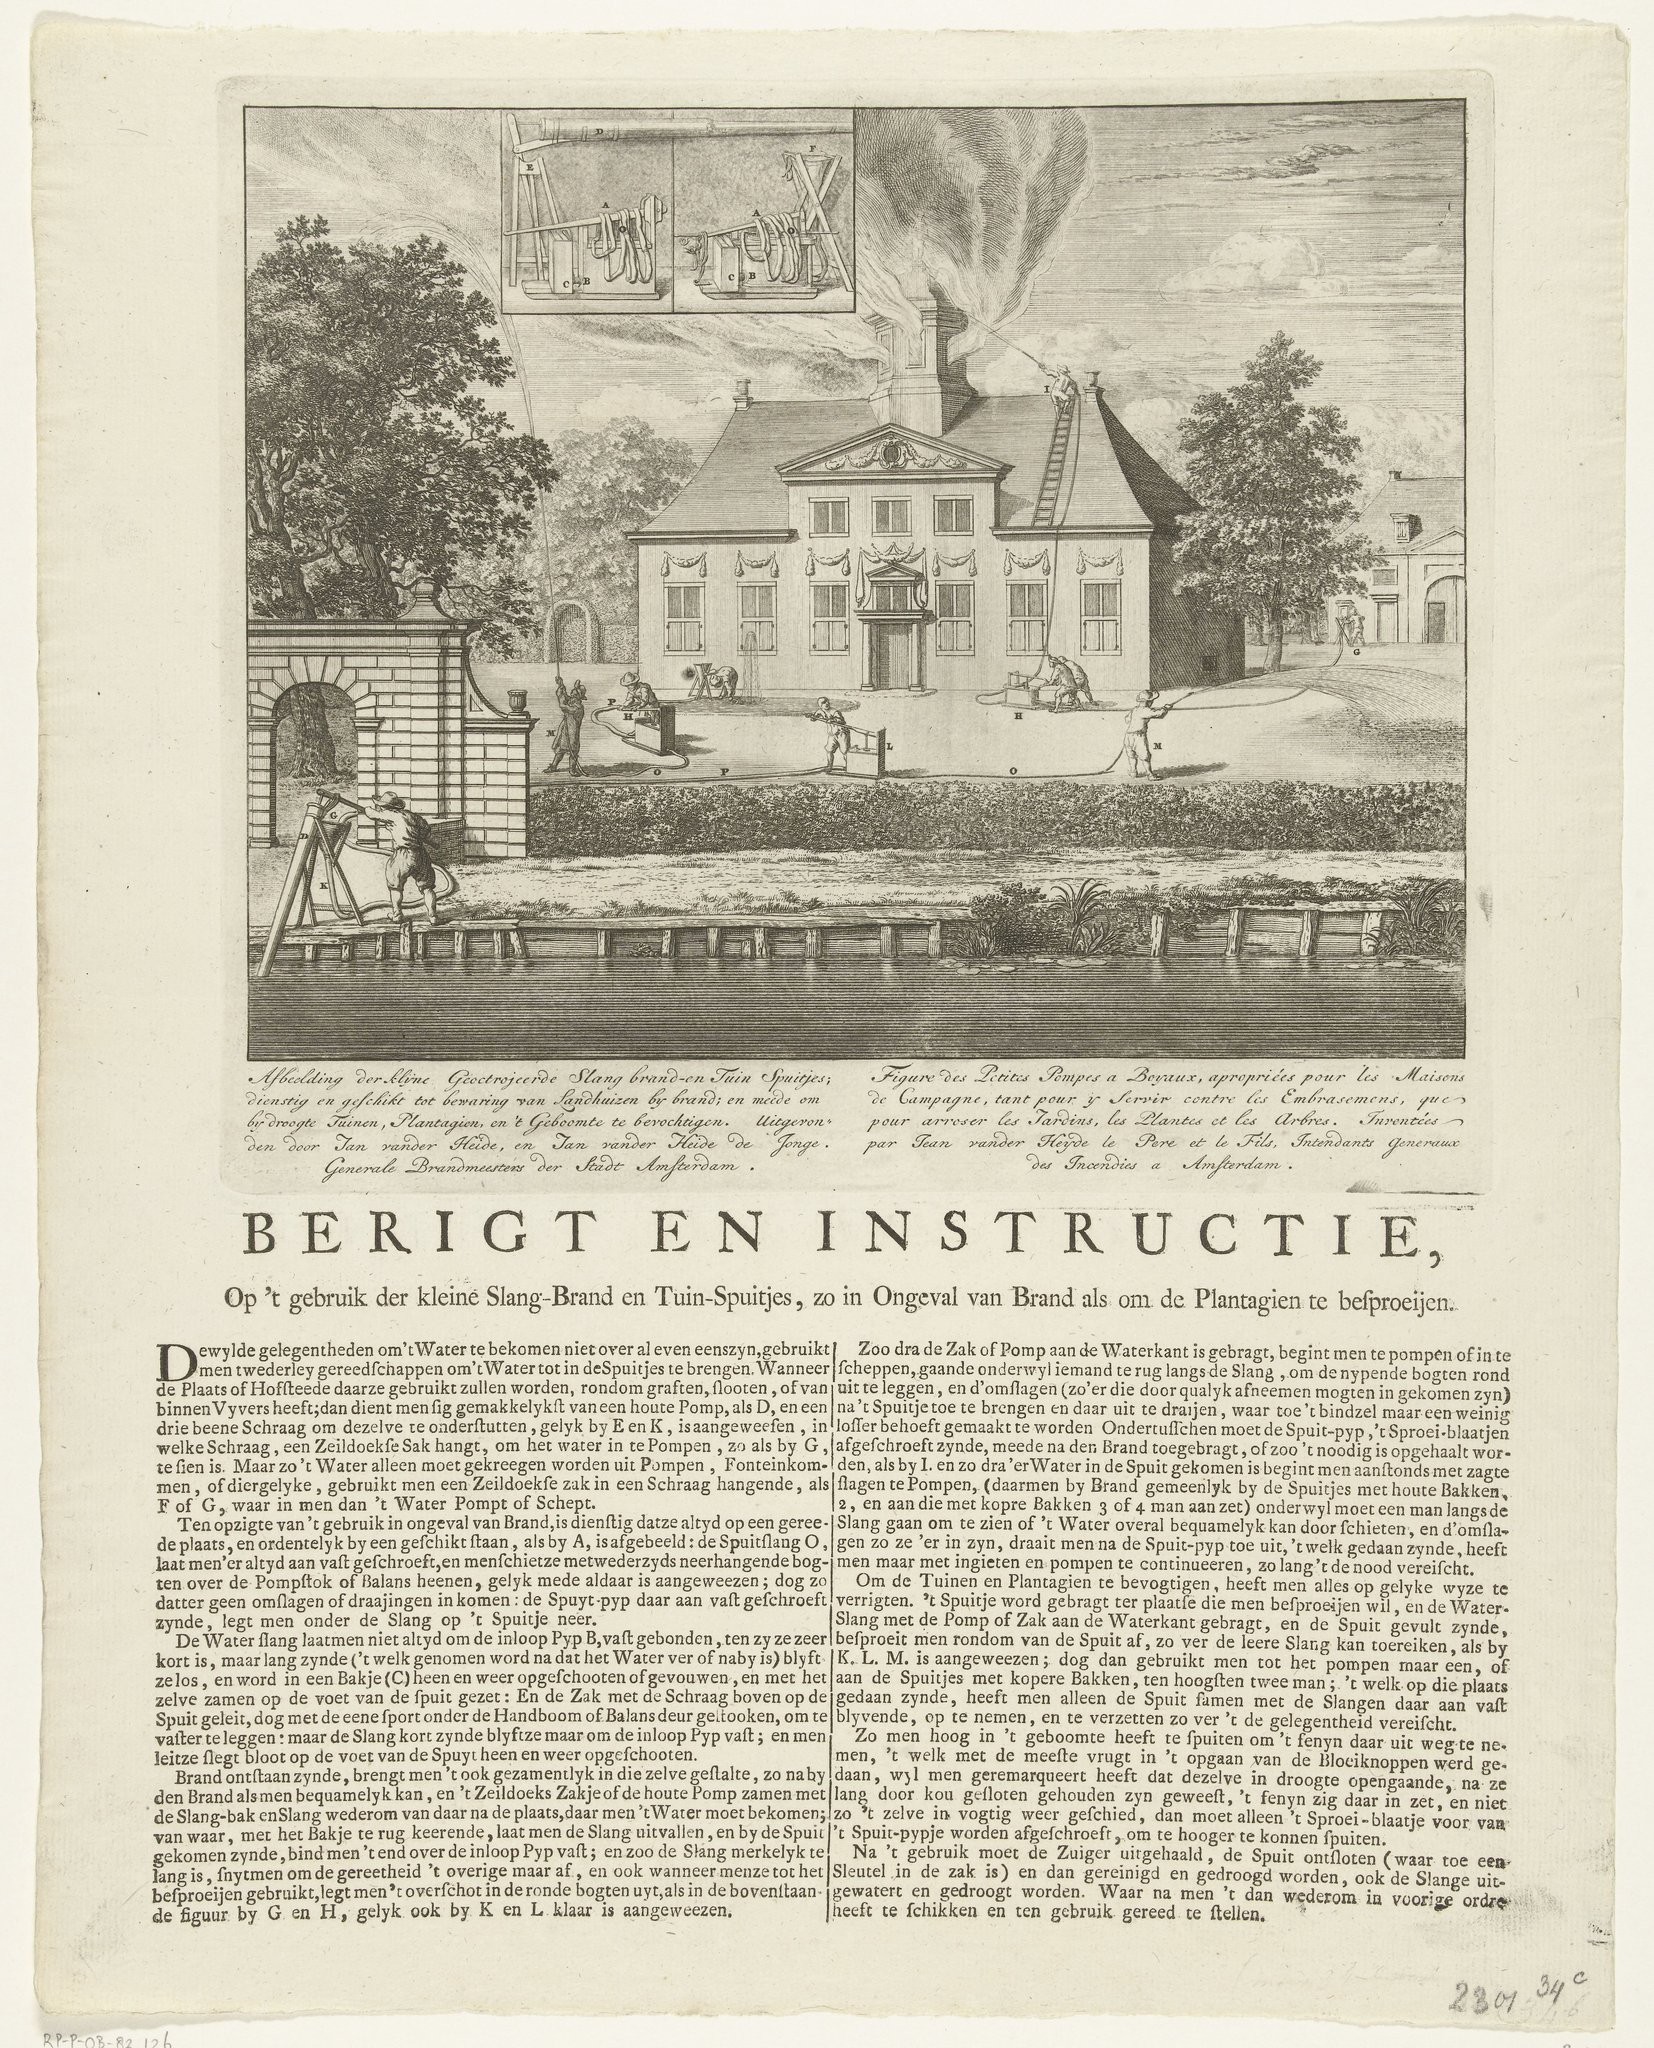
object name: print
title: Afbeelding der klyne Geoctrojeerde Slang brand- en Tuin Spuitjes; dienstig en geschikt tot bewaring van Landhuizen by brand; en meede om by droogte Tuinen, Plantagien, en 't Geboomte te bevochtigen. Uitgevonden en te bekoomen by Jan vander Heide, en Jan vander Heide de Jonge. Generale Brandmeesters der Stadt Amsterdam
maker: jan van der heyden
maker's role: draughtsman, painter, print maker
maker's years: 1637-1712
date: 1690-1710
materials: paper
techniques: engraving, etching, letterpress printing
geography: amsterdam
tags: amsterdam, painter, print maker, draughtsman, jan van der heyden, jan van der heyden (de jonge), watering plants, fire-extinguishing equipment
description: Instructie voor het gebruik van de slangbrandspuiten bij een landhuis om zowel de planten te kunnen besproeien als branden te blussen, ca. 1700. Voorstelling met onderschrift van 5 regels in het Nederlands en Frans. Gedrukt op een blad met tekst over de instructie in 2 kolommen in het Nederlands. Behoort tot de bijprenten bij het Brandspuitenboek van Jan van der Heyden.